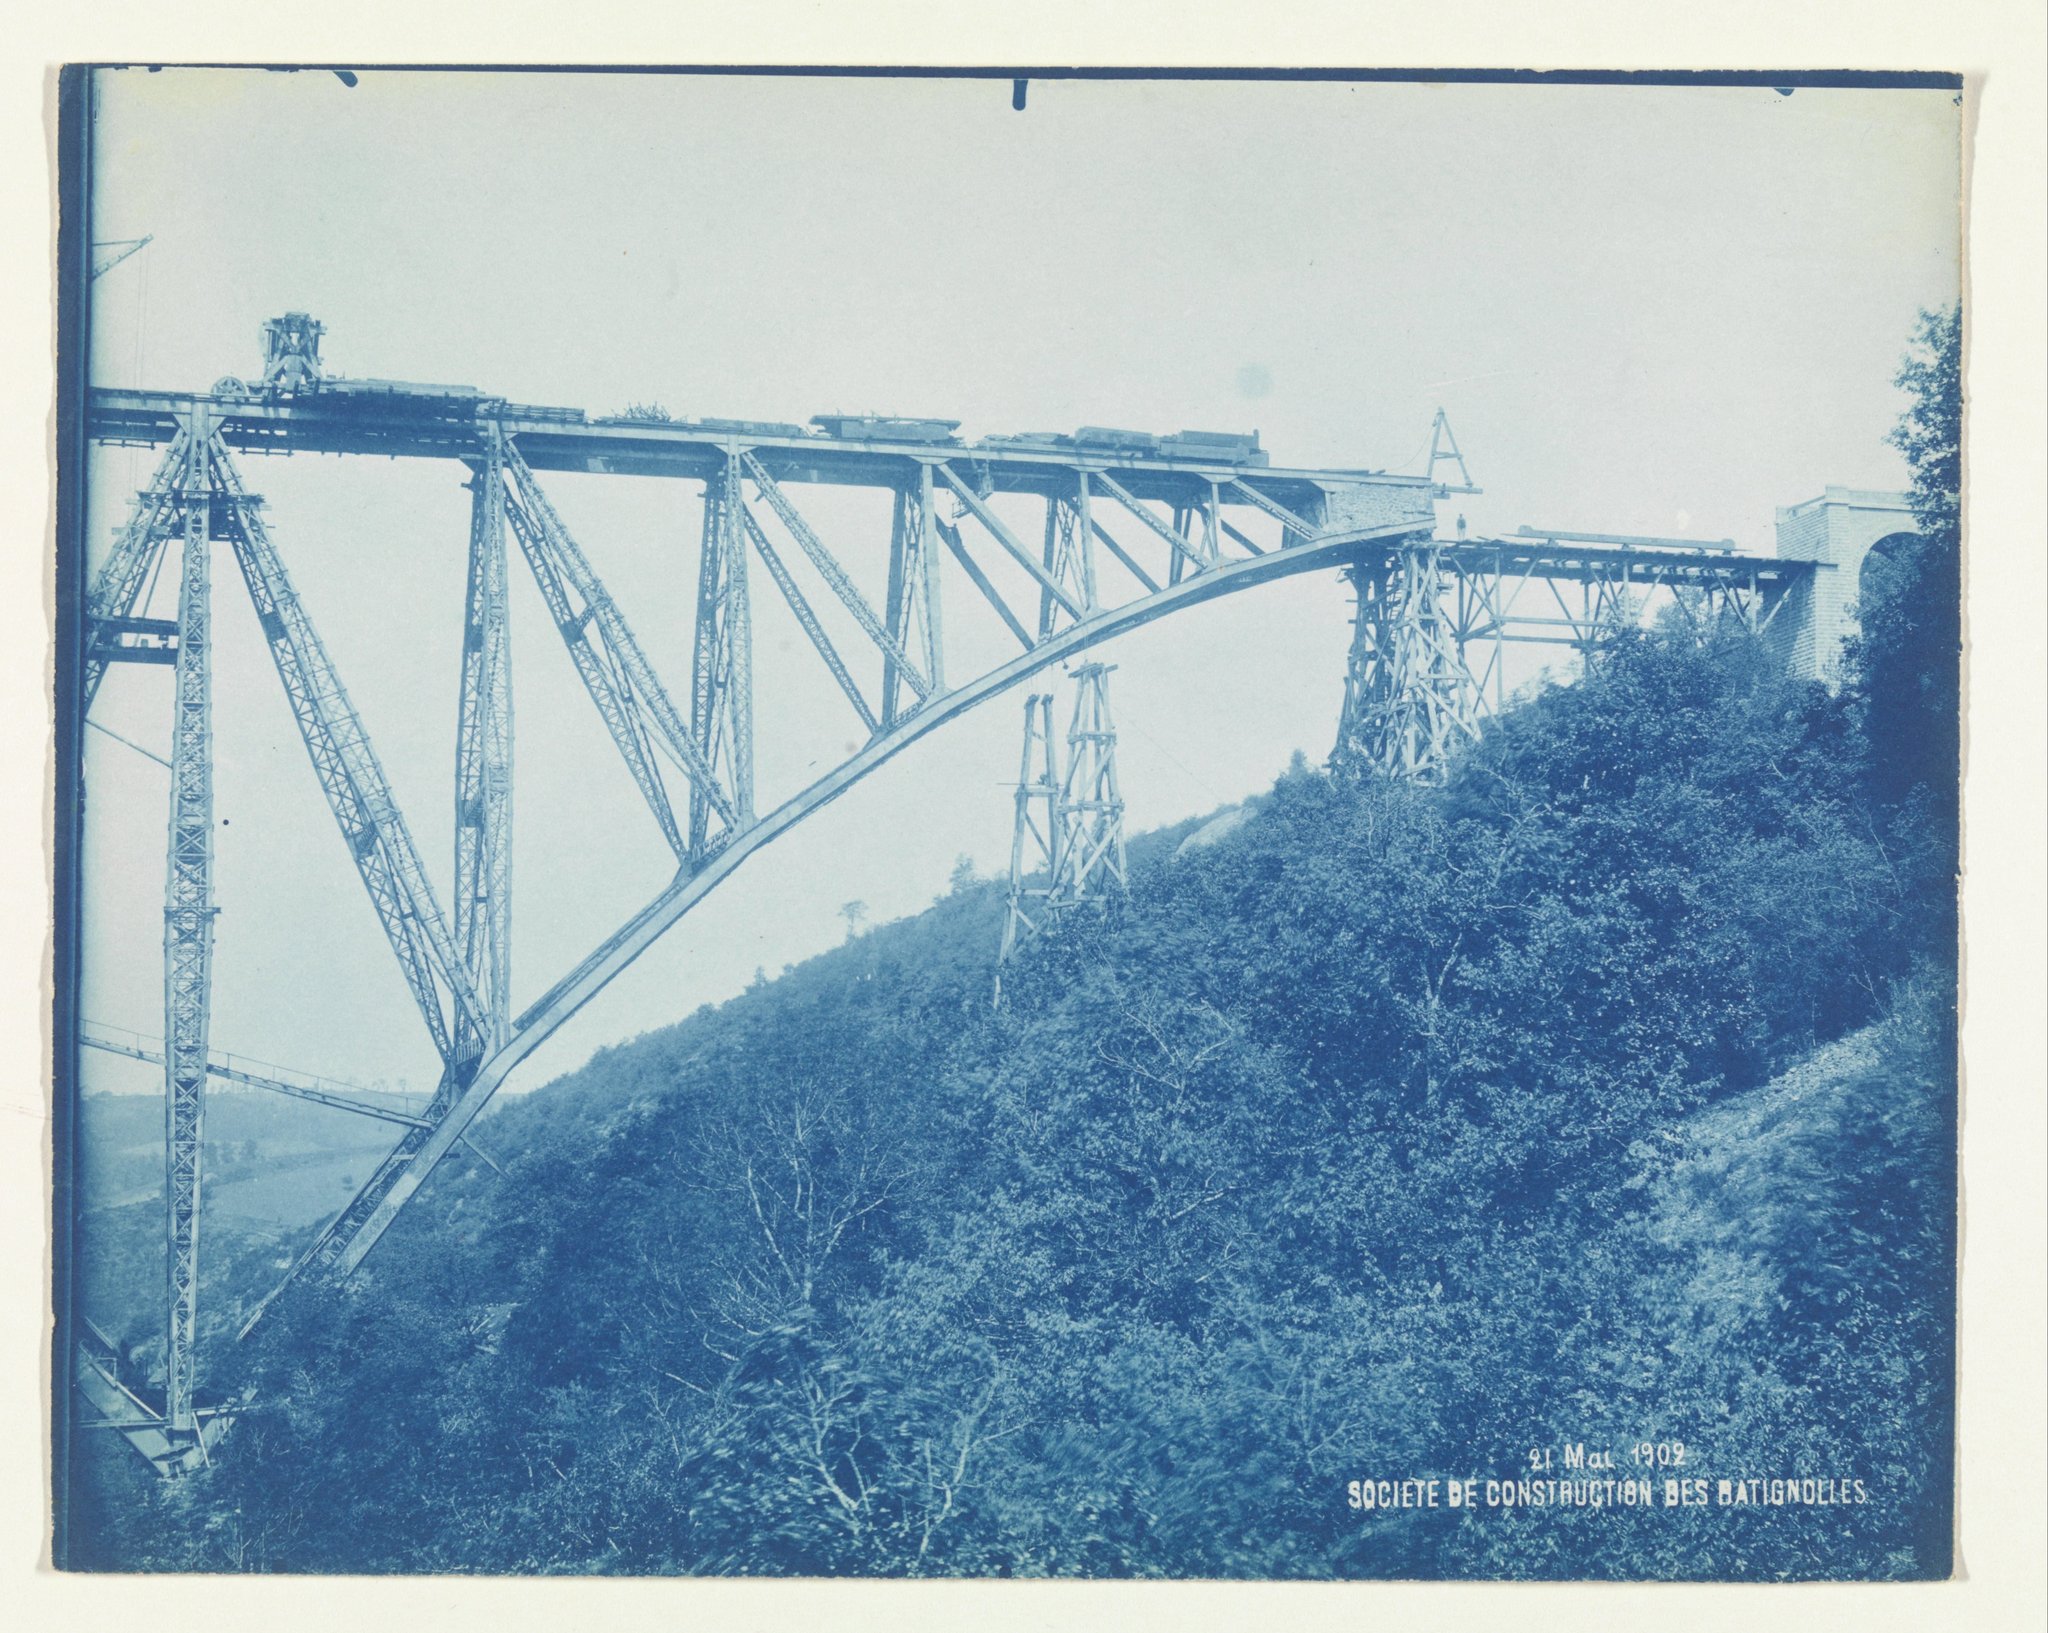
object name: photograph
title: Aanleg van het Viaur Viaduct in Frankrijk door de Societé de Construction des Battignolles, 21 mei 1902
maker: Anonymous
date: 1902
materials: photographic support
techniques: cyanotype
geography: france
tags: viaduct, making the overground structures (~ building activities)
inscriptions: date: ‘21 Mai 1902 // SOCIETÉ DE CONSTRUCTION DES BATIGNOLLES’